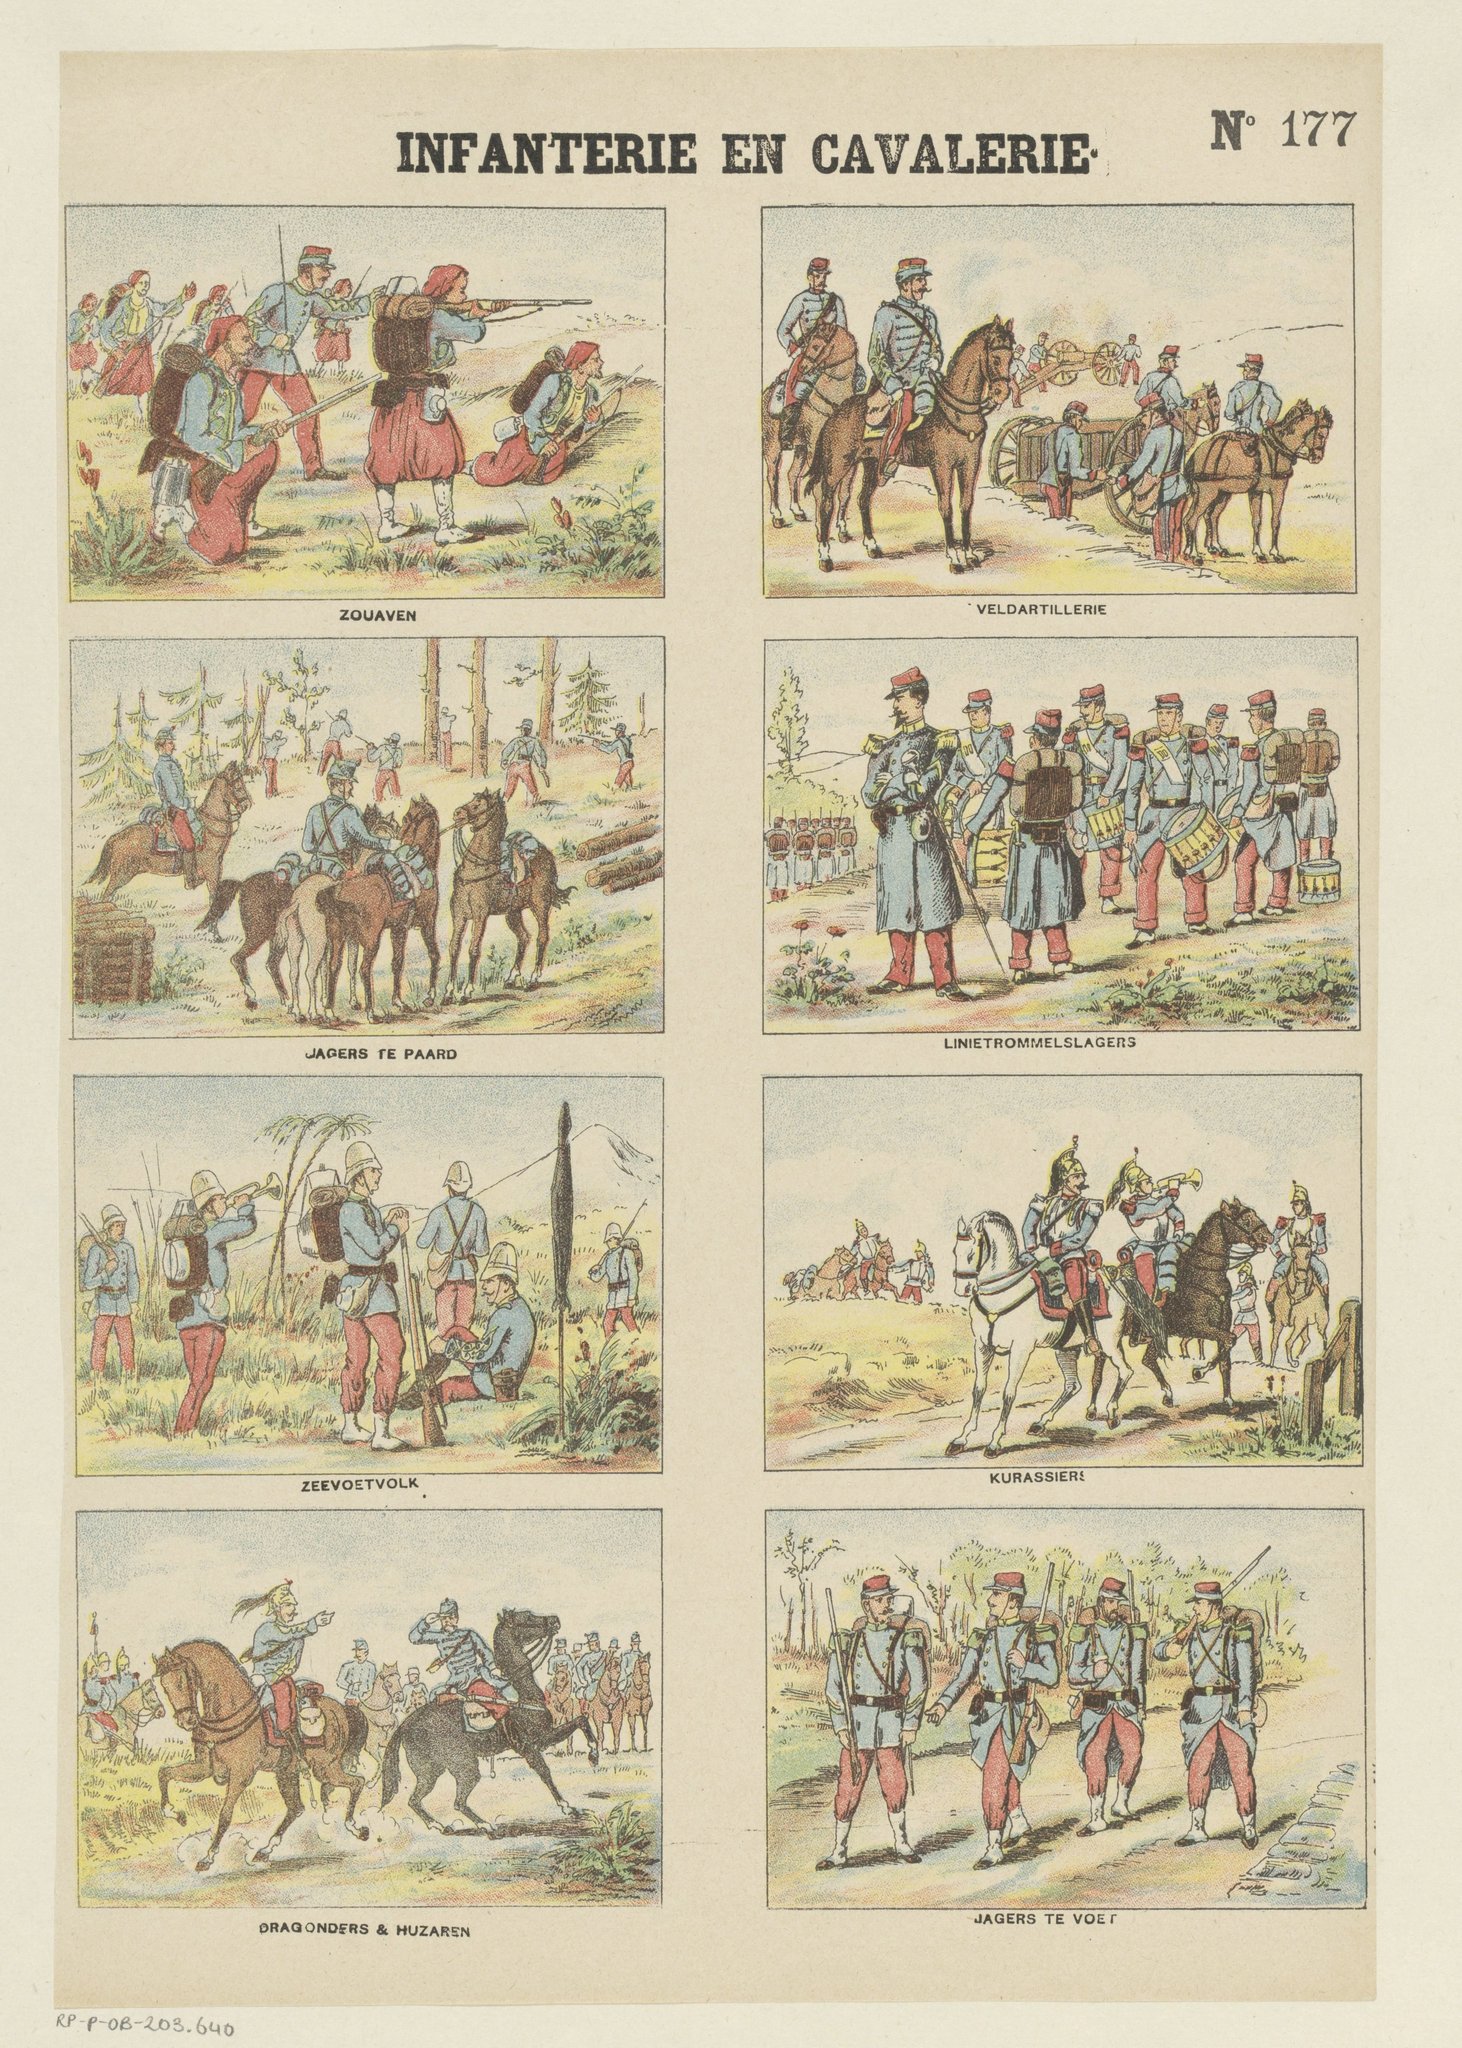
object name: popular print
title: Infanterie en cavalerie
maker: Anonymous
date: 1894-1959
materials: paper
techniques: lithograph, letterpress printing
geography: liège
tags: warfare; military affairs (+ cavalry, horsemen), the soldier; the soldier's life, (military) uniforms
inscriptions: collector's mark: Lugt 2760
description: Blad met 8 voorstellingen van militairen, bijvoorbeeld zouaven, veldartilleristen en huzaren. Onder elke afbeelding een onderschrift. Genummerd rechtsboven: No 177.